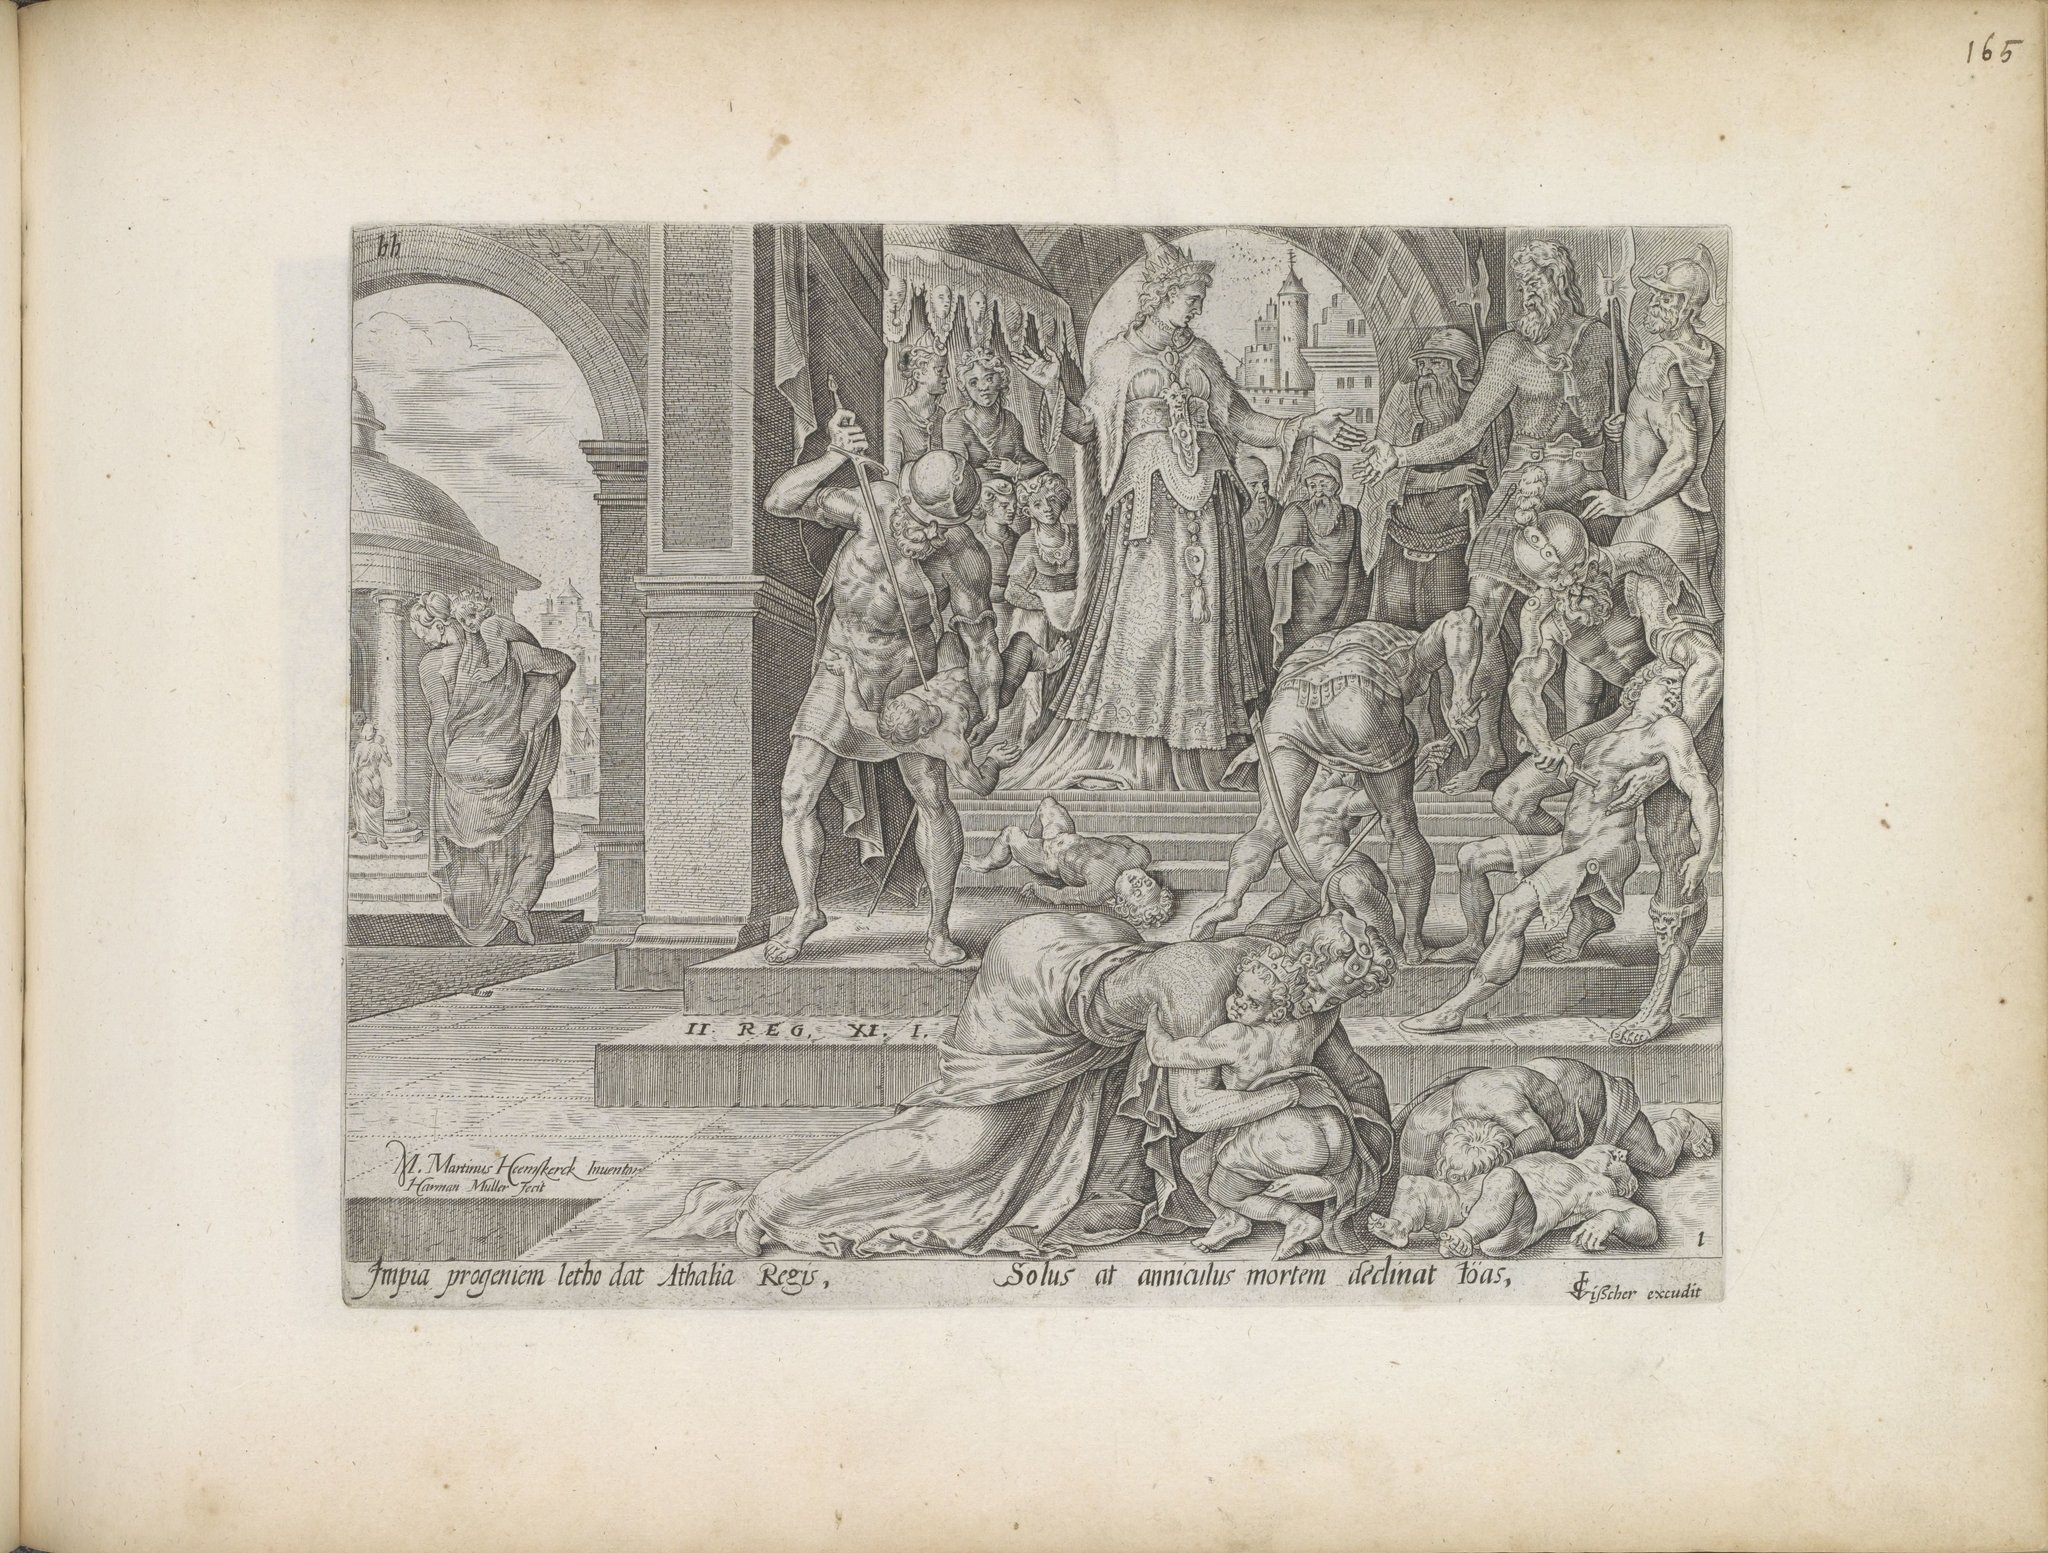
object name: album leaf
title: Koningin Atalja laat de koningskinderen doden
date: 1565-1569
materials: paper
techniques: engraving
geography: amsterdam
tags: joash is rescued by his aunt jehosheba, athaliah has all the members of the royal family killed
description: Atalja, die hoorde dat haar zoon koning Achazja was omgekomen, geeft opdracht om alle koningskinderen te doden, zodat zij koningin kan worden. Op de trap doden soldaten de kinderen. Links wordt Achazja's zoon Joas door zijn tante gered. Op de trap een verwijzing naar de Bijbeltekst in 2 Kon. 11:1. Onderaan in de marge een vers in het Latijn over de voorstelling. Deze prent maakt deel uit van een album.